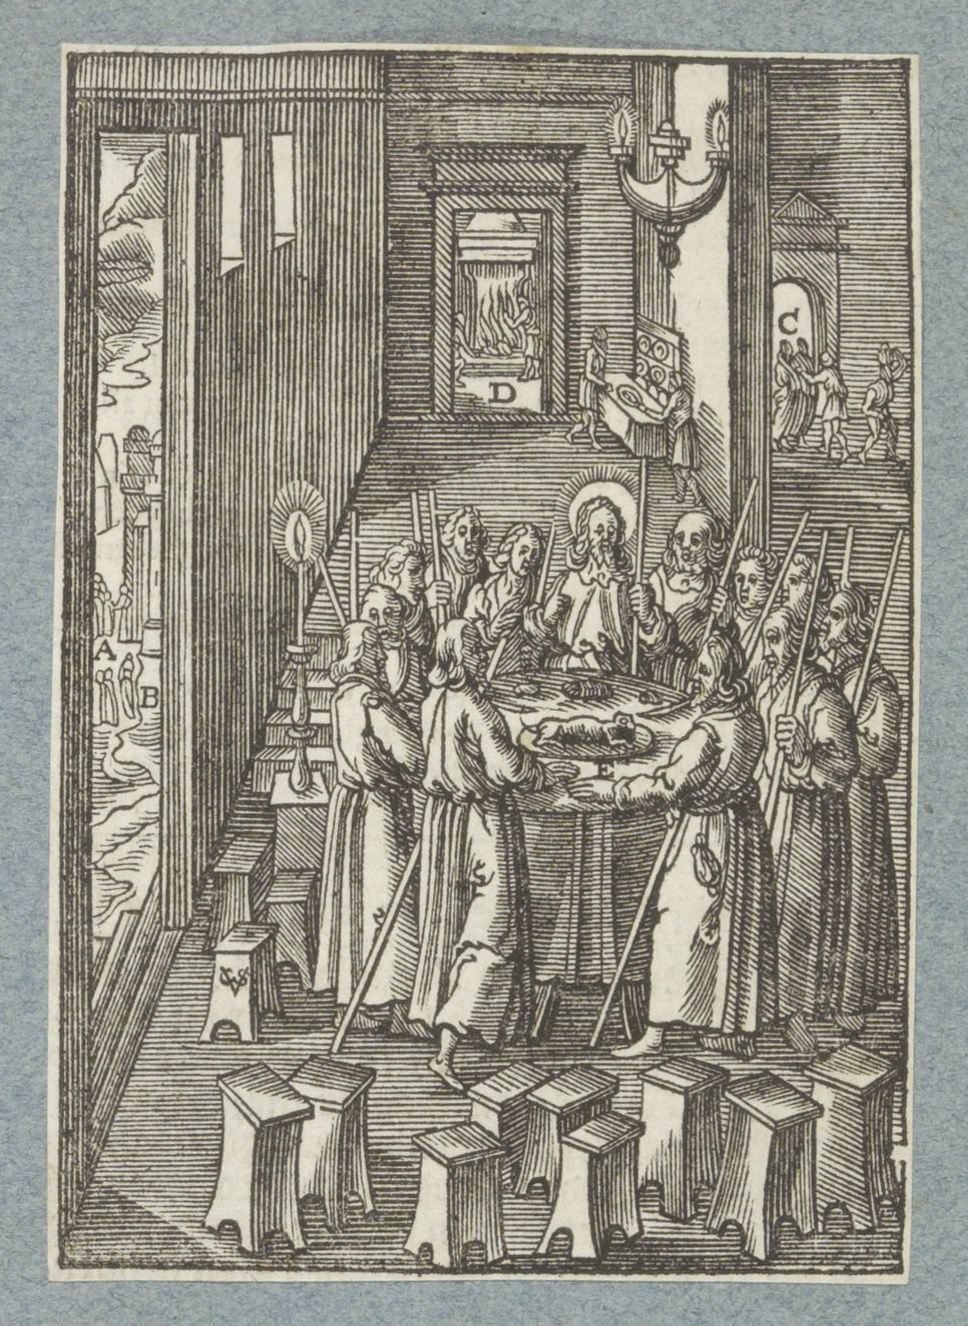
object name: book illustration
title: Pesachmaal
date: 1628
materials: paper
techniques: letterpress printing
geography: antwerp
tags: preparation of the passover ~ last supper (matthew 26:17-20; mark 14:12-17; luke 22:7-14)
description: De prent is afkomstig uit een van de uitgaven van P.J. Paets uit Amsterdam. Ze wordt voor het eerst gebruikt in: Thomas à Kempis, Qui sequitur me. Leuven, J. Maes, 1628 [= Amsterdam, P.J. Paets] en Der Zielen Lust-hof. Leuven, I.Jacbosz voor P.J. Paets [= Amsterdam, P.J. Paets], 1629. De voorstelling is gekopieerd naar een prent van Johannes Wierix voor: Nadal, Jerónimo. Evangelicae Historiae Imagines. Antwerpen, M. Nutius, 1593.